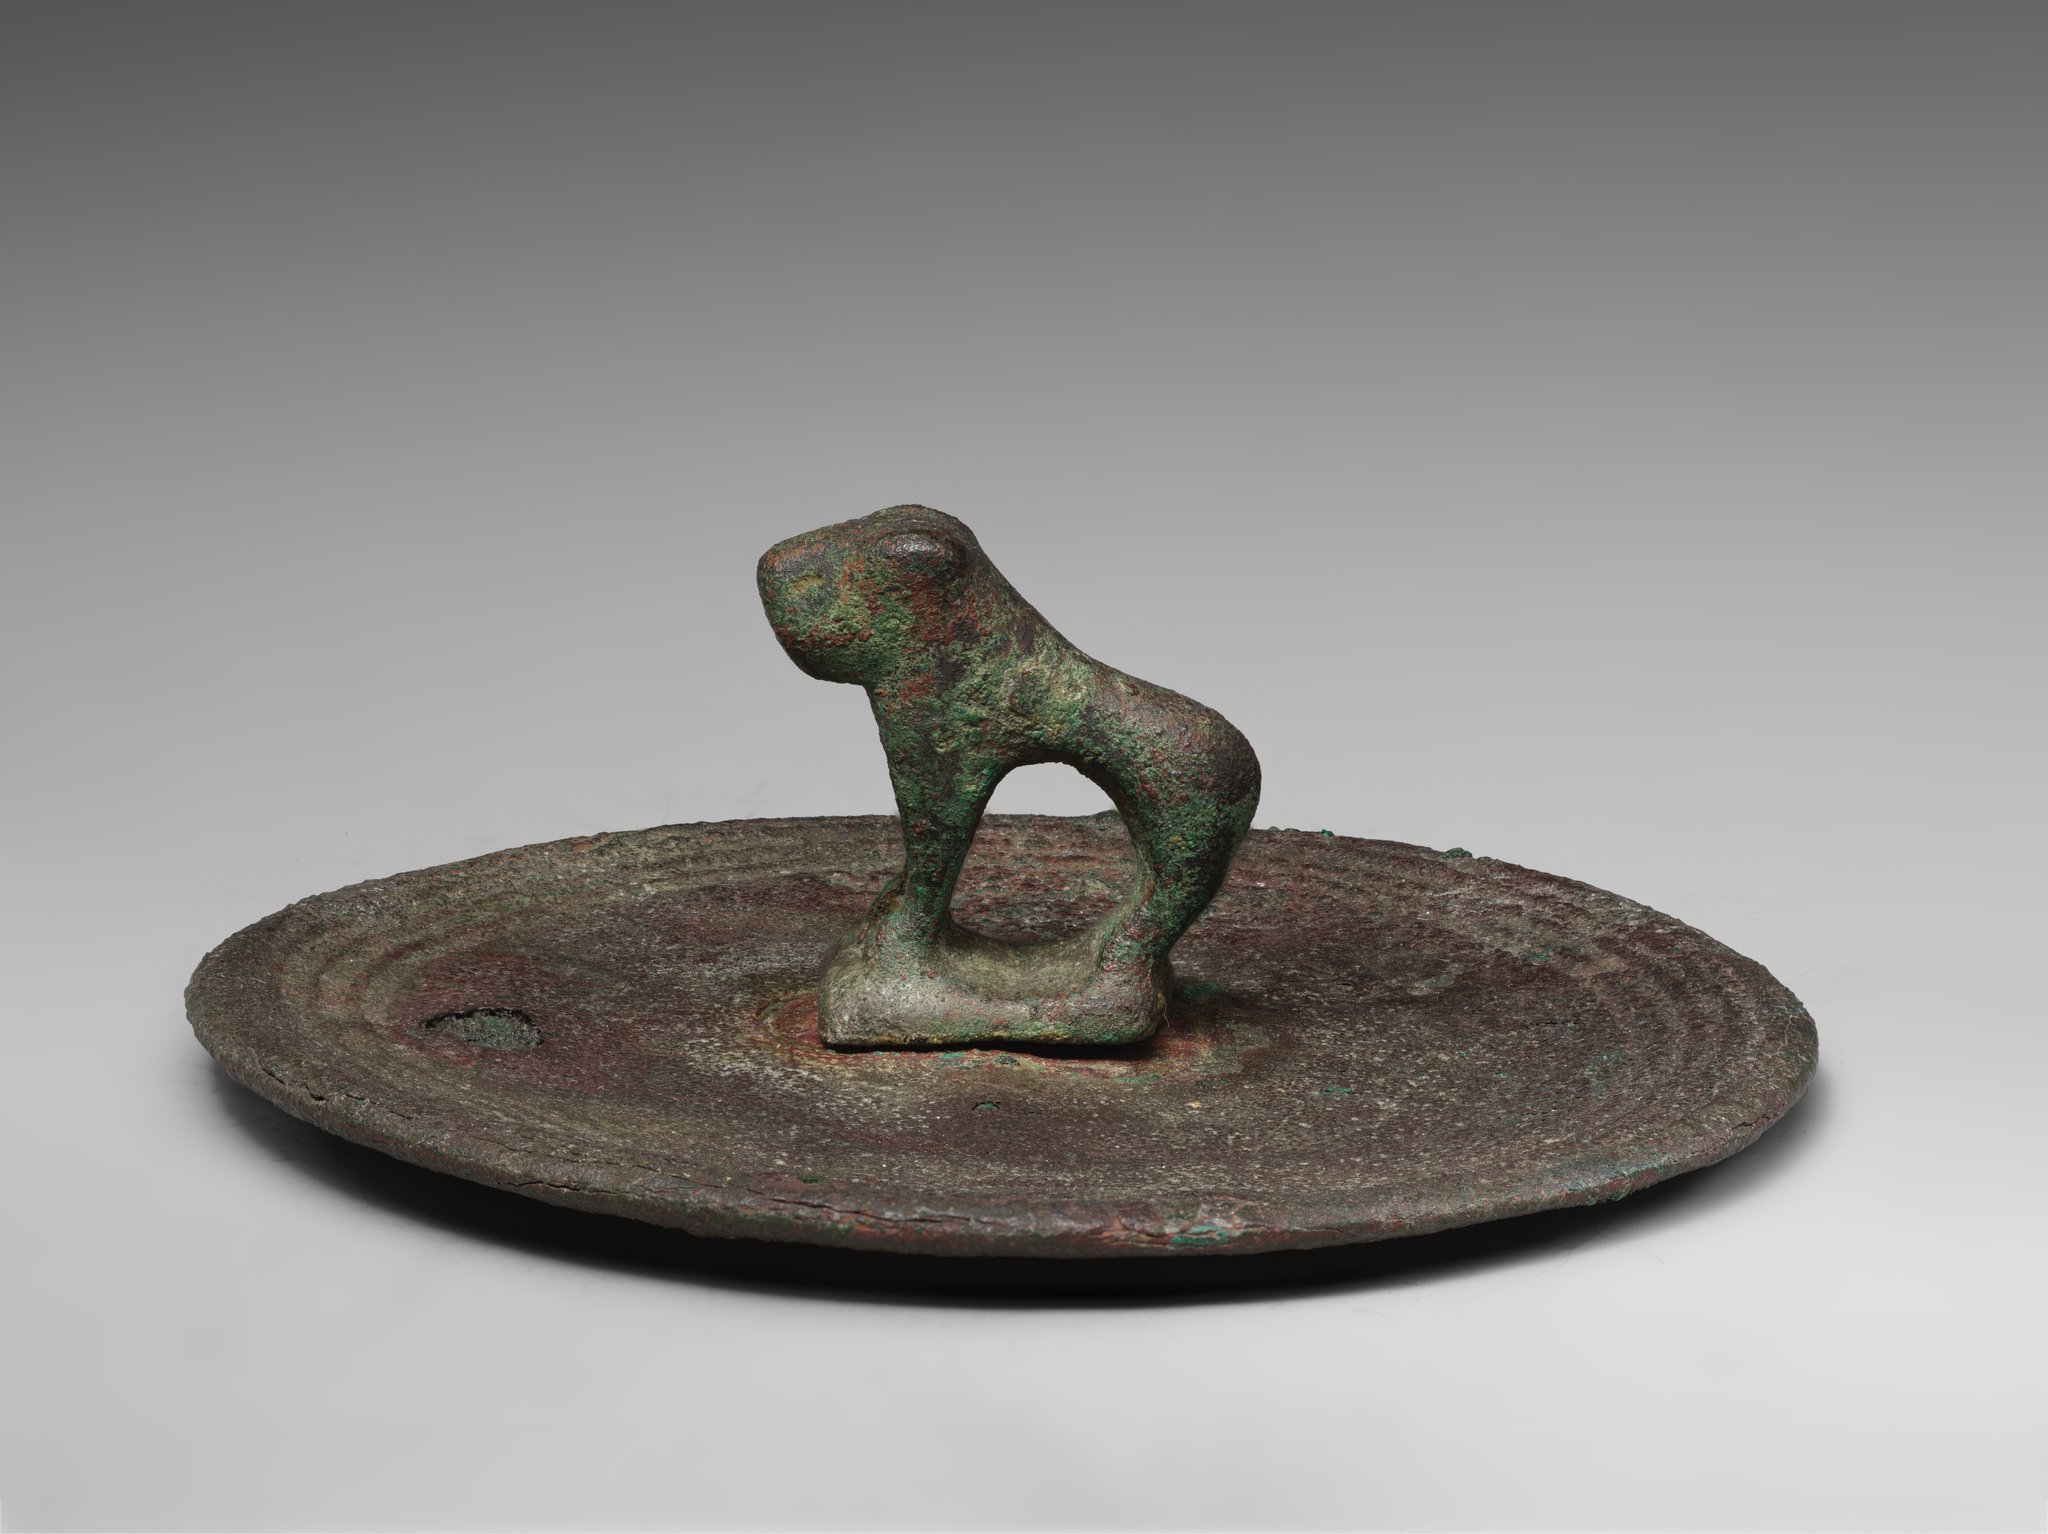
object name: mirror or lid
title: Mirror or lid with handle in the form of a lion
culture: sasanian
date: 501-700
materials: bronze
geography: iran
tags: lions